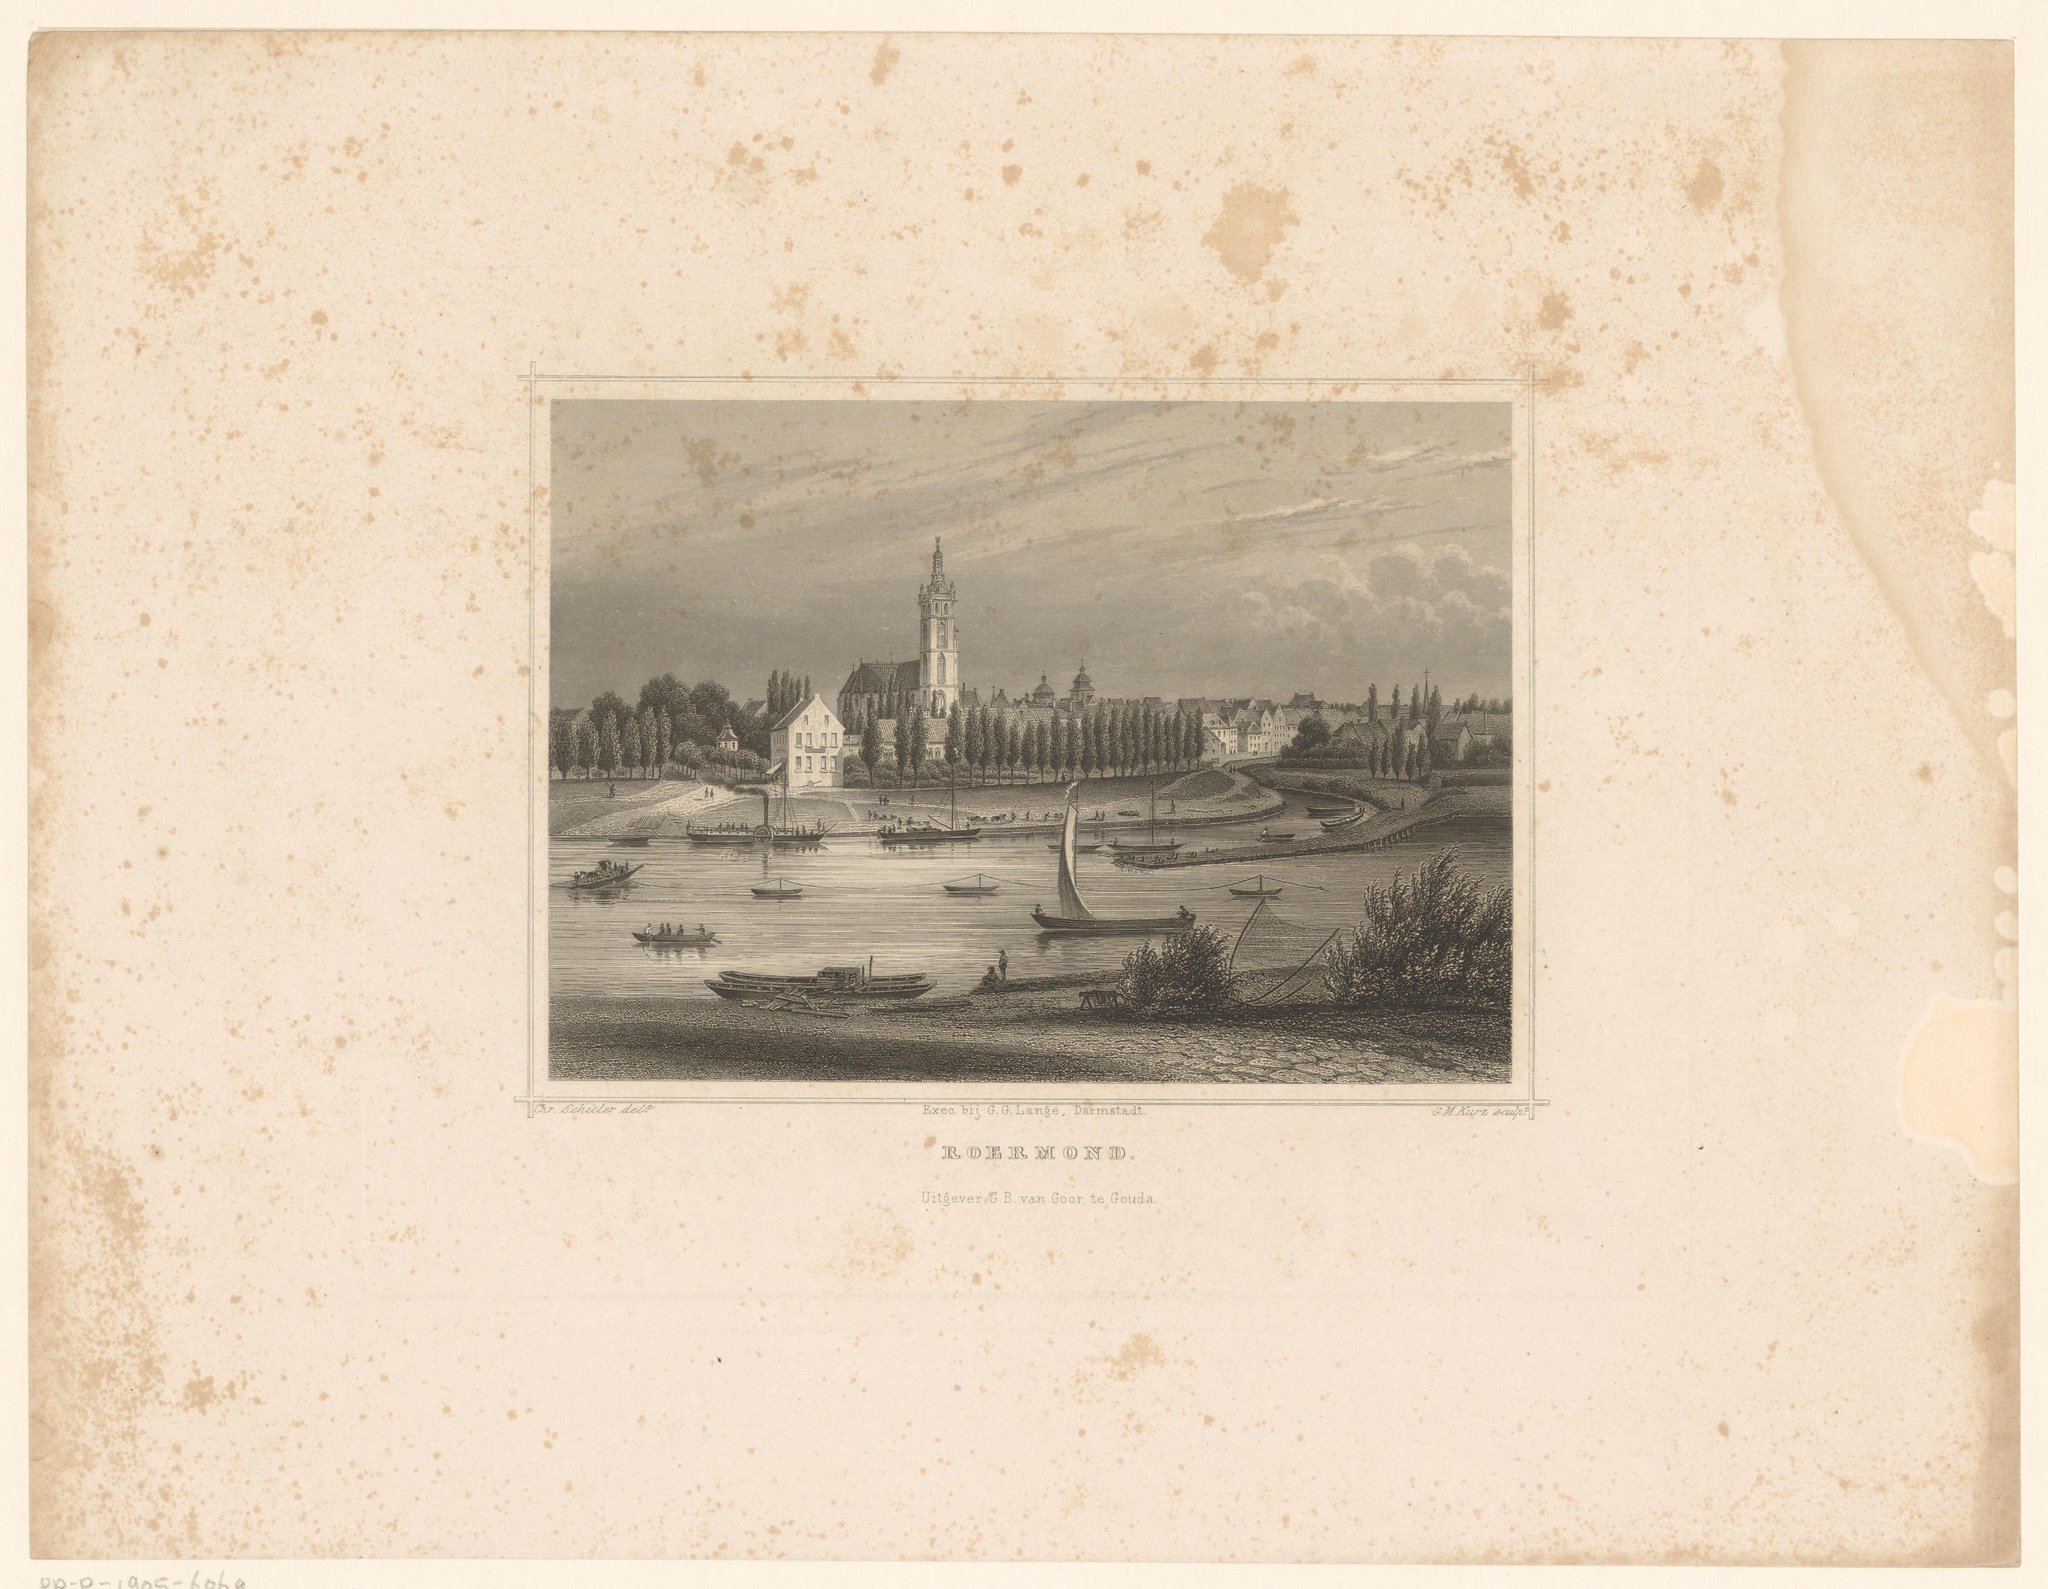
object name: print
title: Gezicht op Roermond en de Maas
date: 1839-1871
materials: paper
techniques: engraving, etching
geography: gouda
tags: river bank, traffic on the water, city-view, and landscape with man-made constructions (+ city(-scape) with figures, staffage)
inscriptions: collector's mark: Lugt 2228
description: Deze prent hoort bij een serie van 24 Nederlandse stadsgezichten.